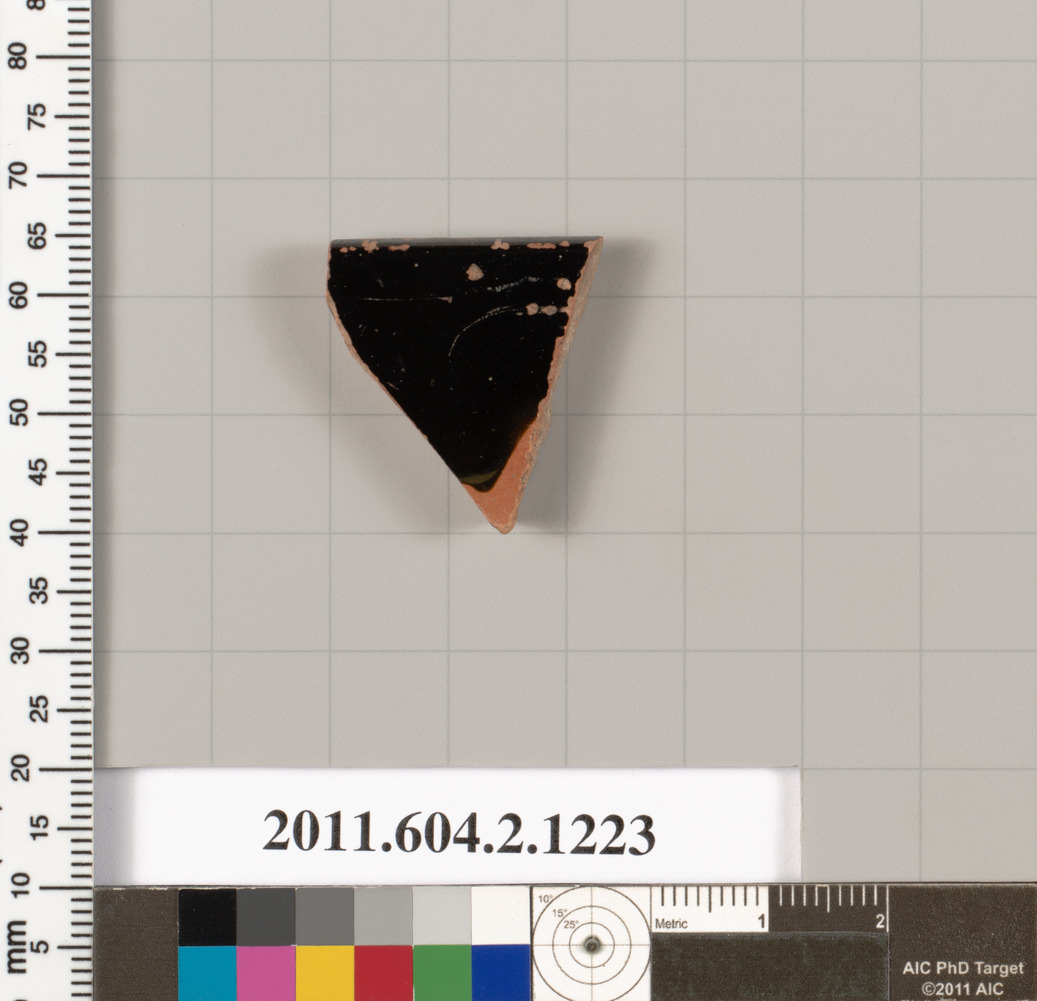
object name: kantharos fragment, head vase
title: Terracotta fragment from a kantharos: head vase?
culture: greek, attic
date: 475-451 BCE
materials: terracotta